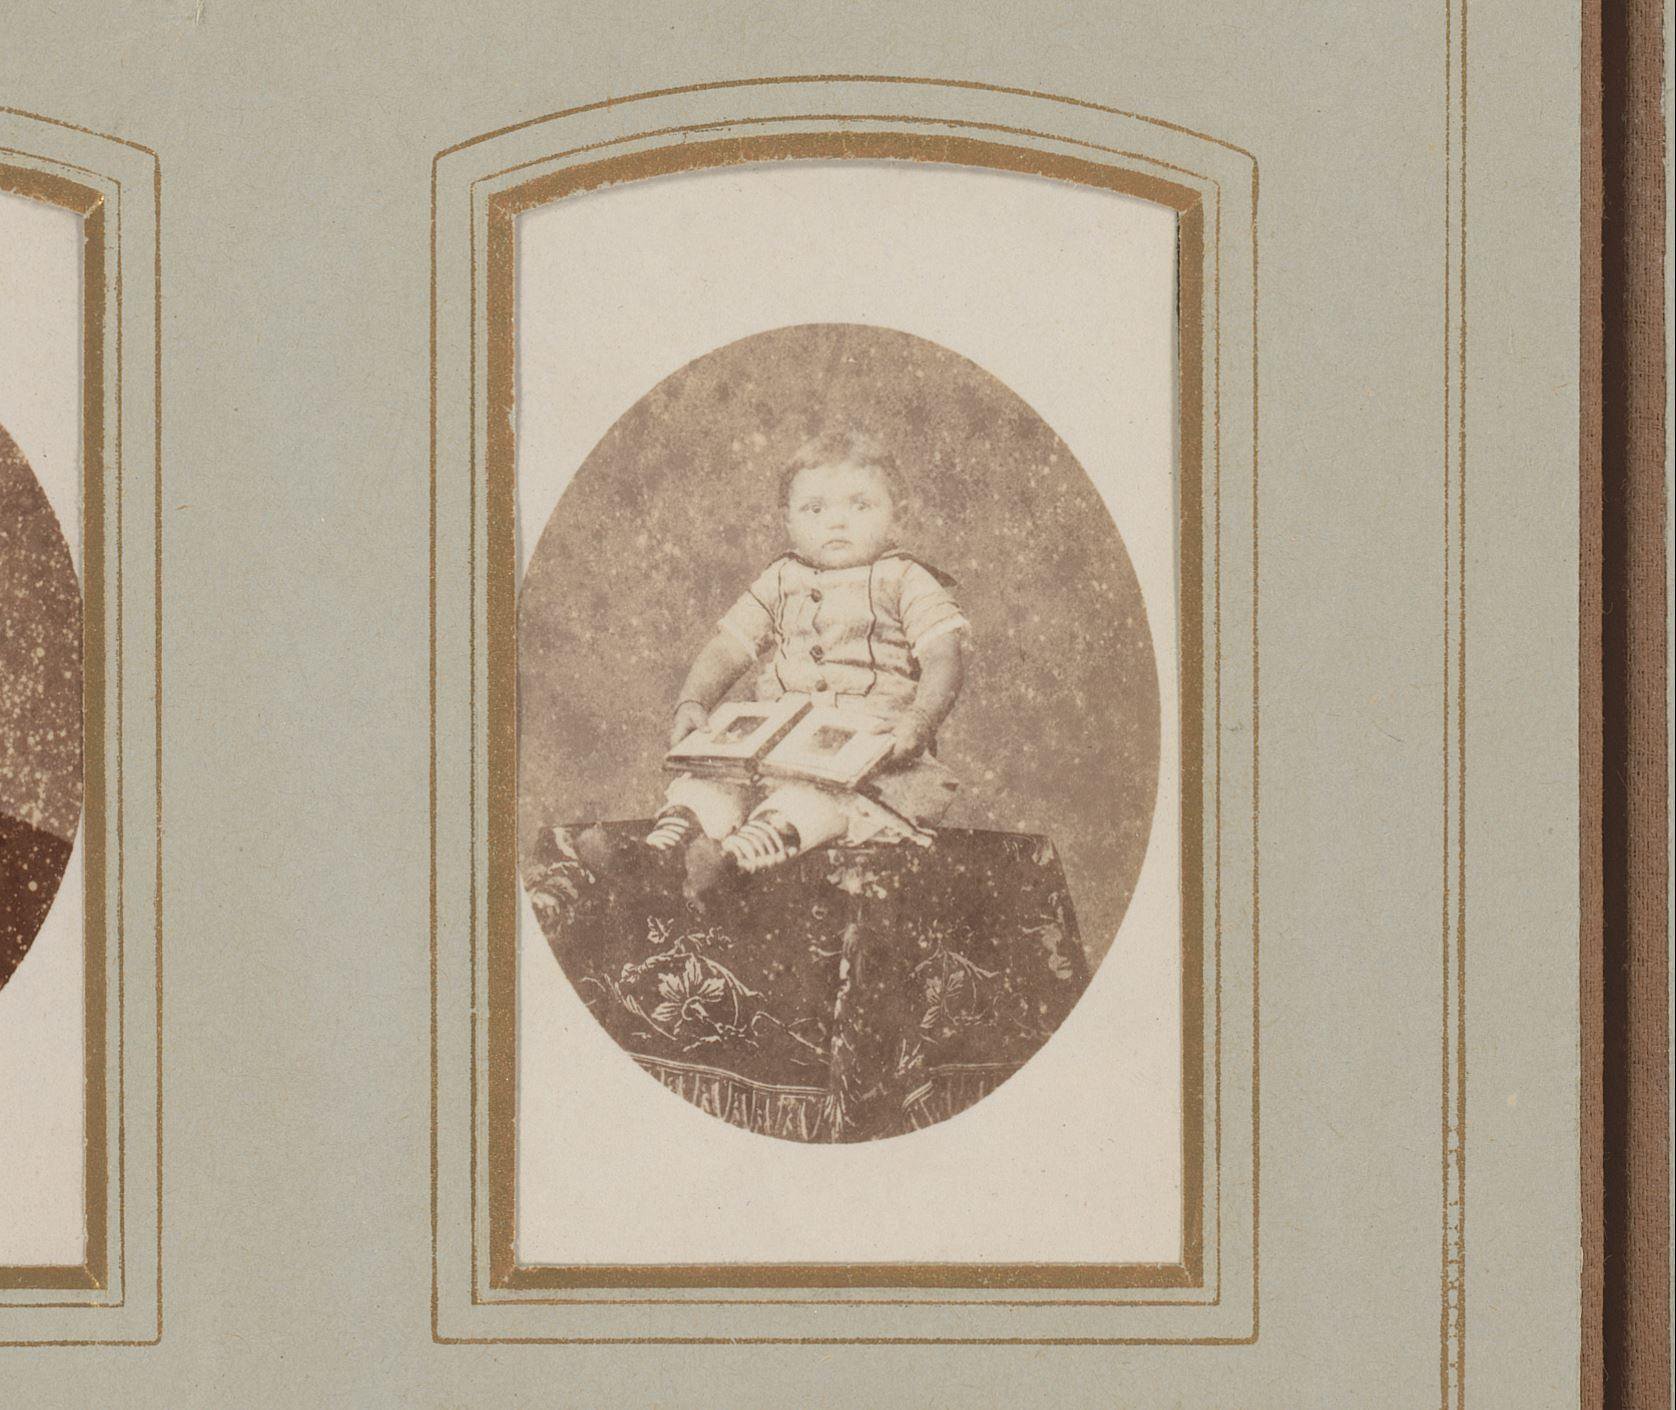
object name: carte de visite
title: Portret van een baby met boek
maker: nicolaas jelles van ulsen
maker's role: fotograaf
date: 1880-1884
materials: cardboard, photographic support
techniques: albumen print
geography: purmerend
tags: historical persons, book, infant, baby ~ the ages of man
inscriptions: inscription: ‘N. J. VAN ULSEN/ PHOTOGRAAF/ KERKSTRAAT/ over de R.C.Kerk 95/ PURMEREND.’